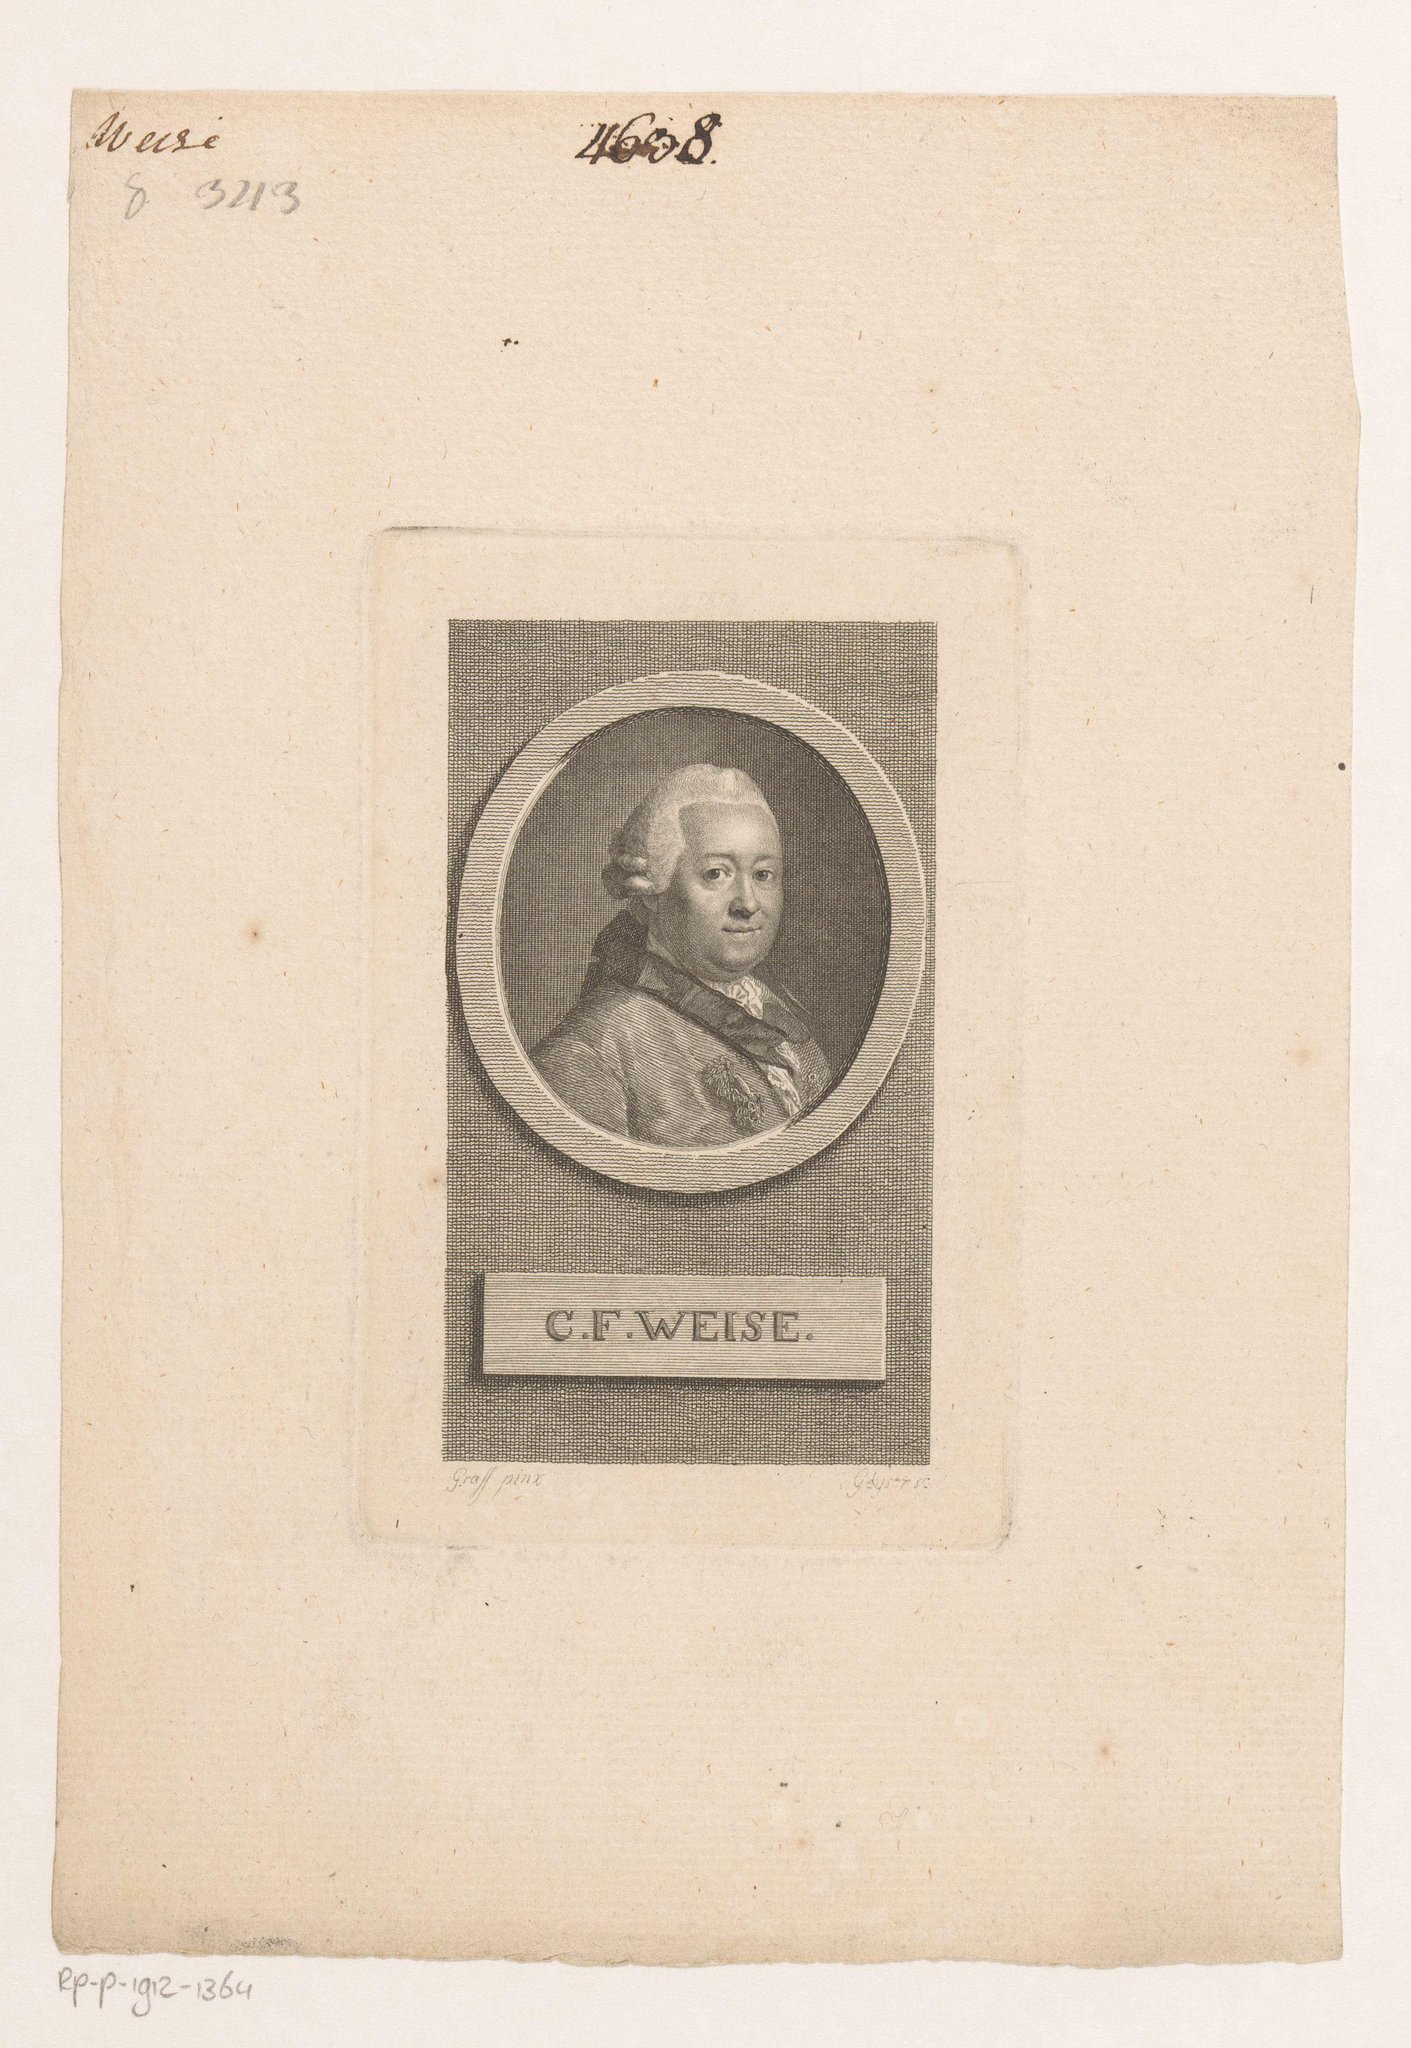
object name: print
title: Portret van Christian Felix Weisse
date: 1752-1803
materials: paper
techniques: engraving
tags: historical persons, writer, poet, author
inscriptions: collector's mark: Lugt 2228